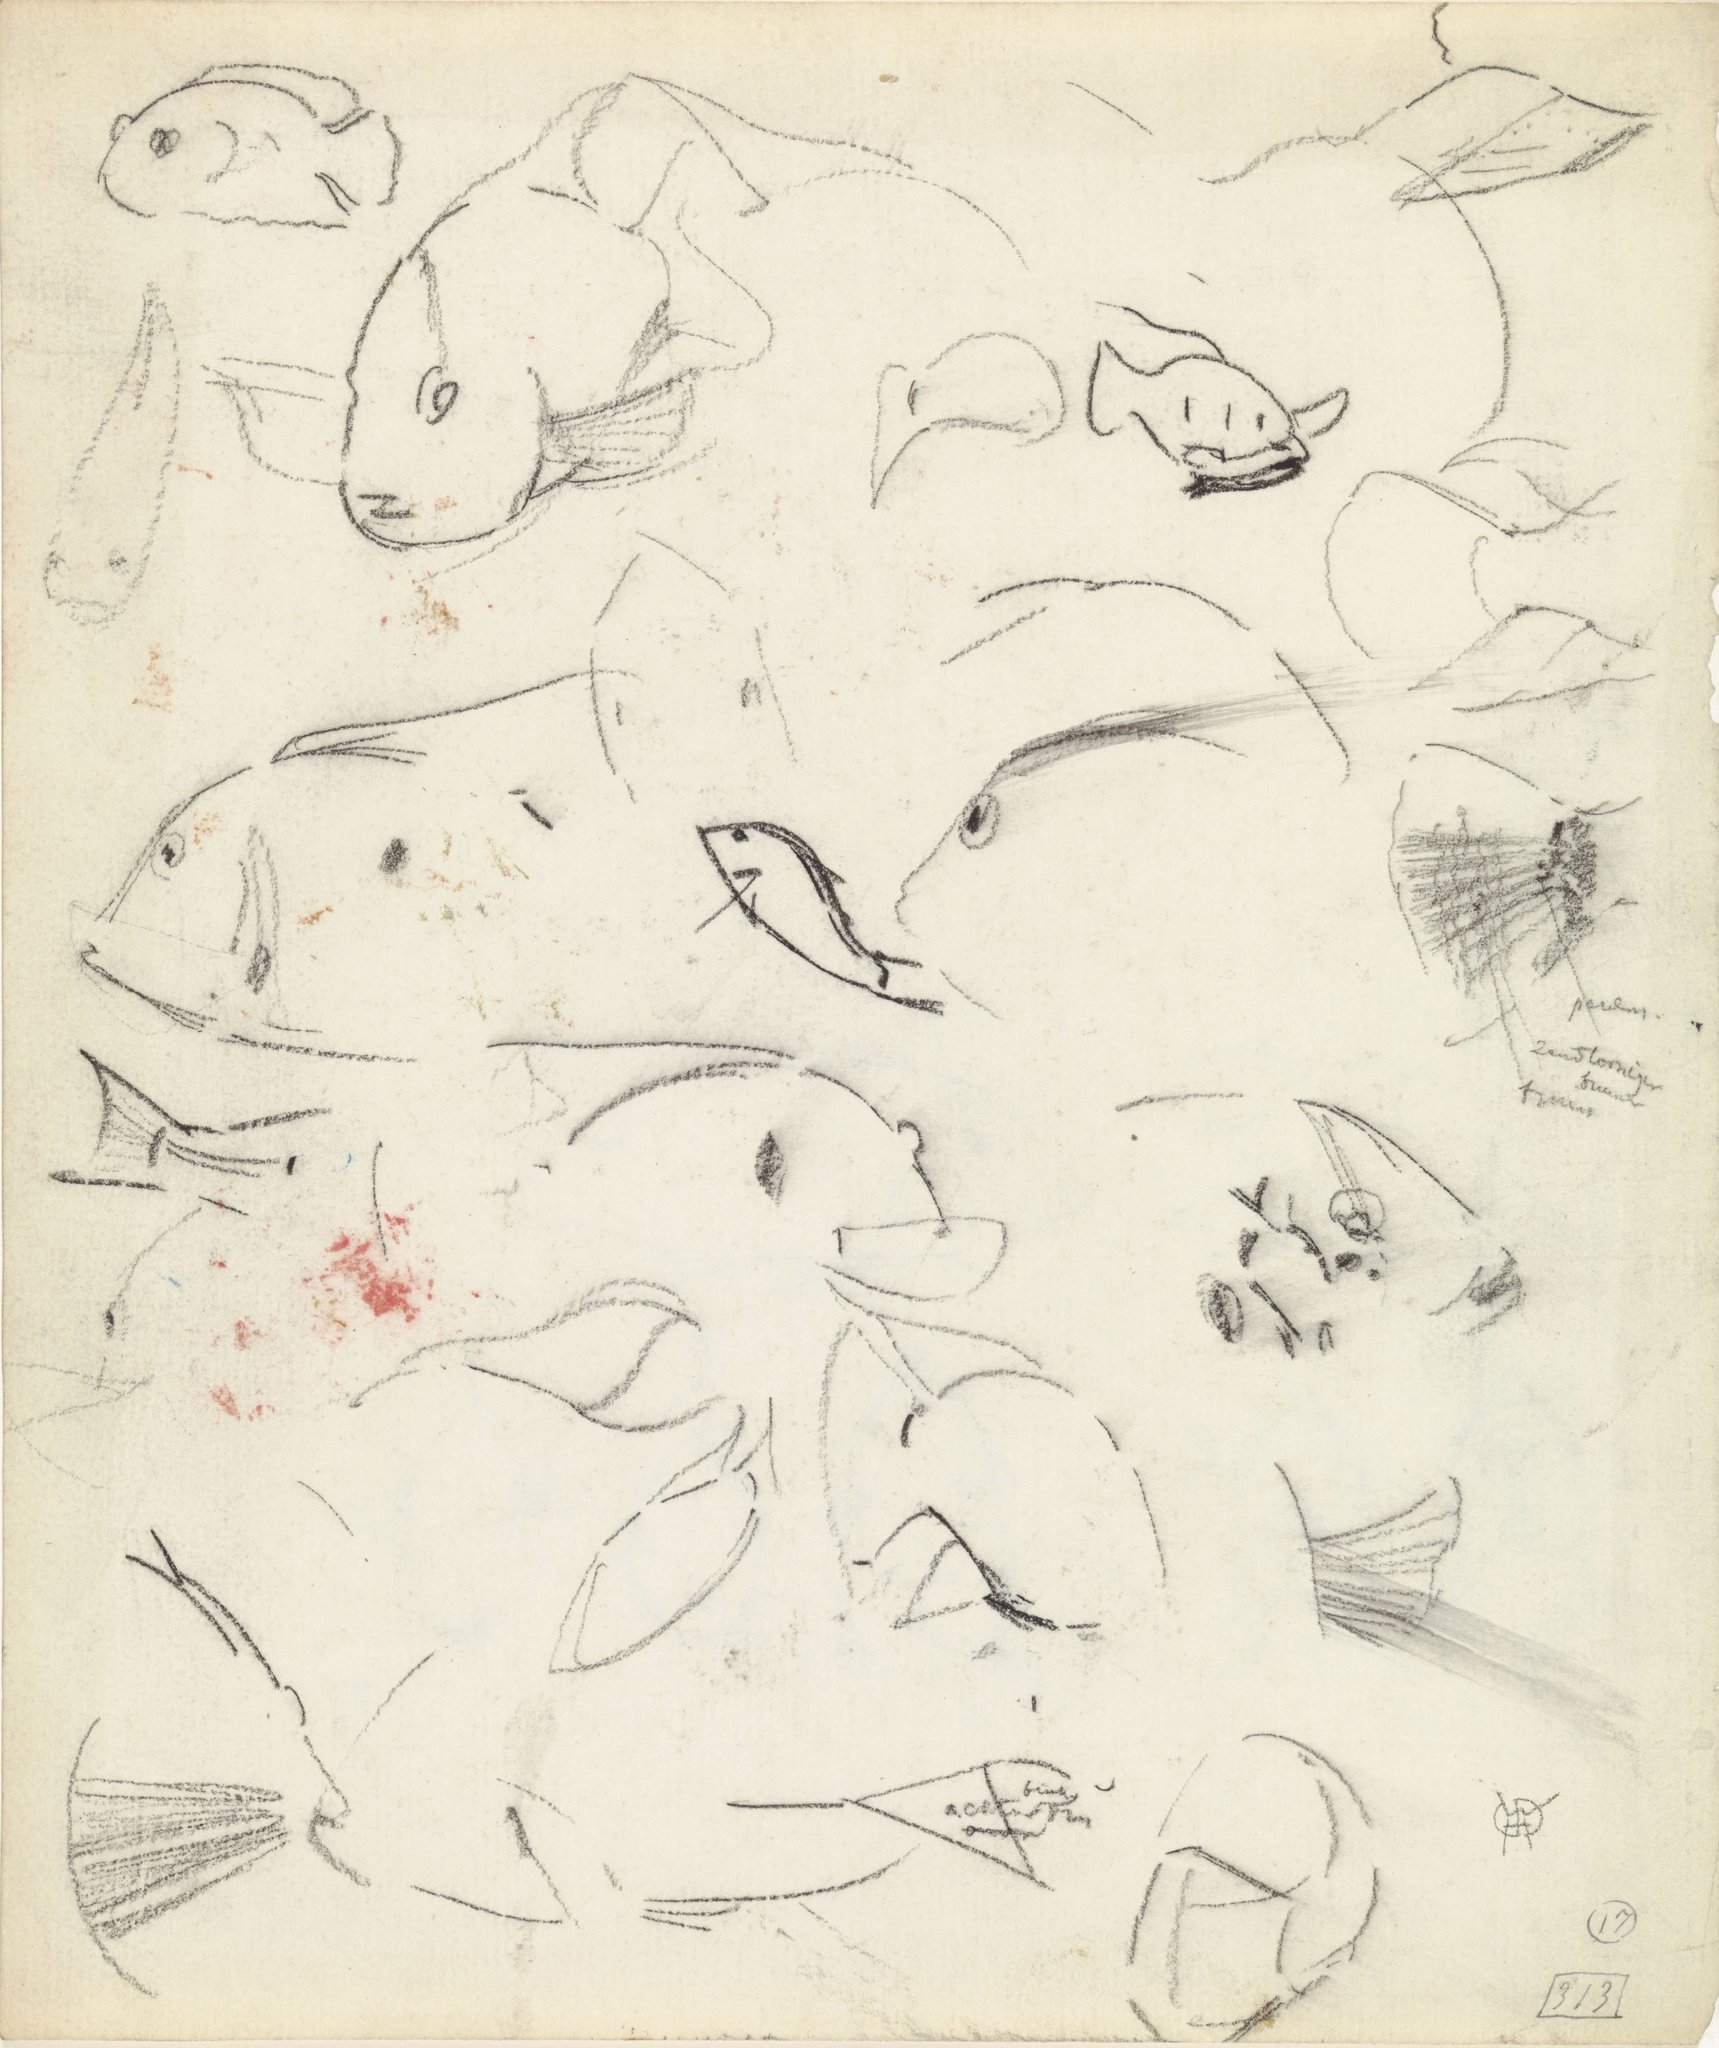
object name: drawing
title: Studies van vissen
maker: gerrit willem dijsselhof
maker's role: designer, draughtsman, print maker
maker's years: 1866-1924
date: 1876-1924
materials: chalk, paper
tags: bony fishes